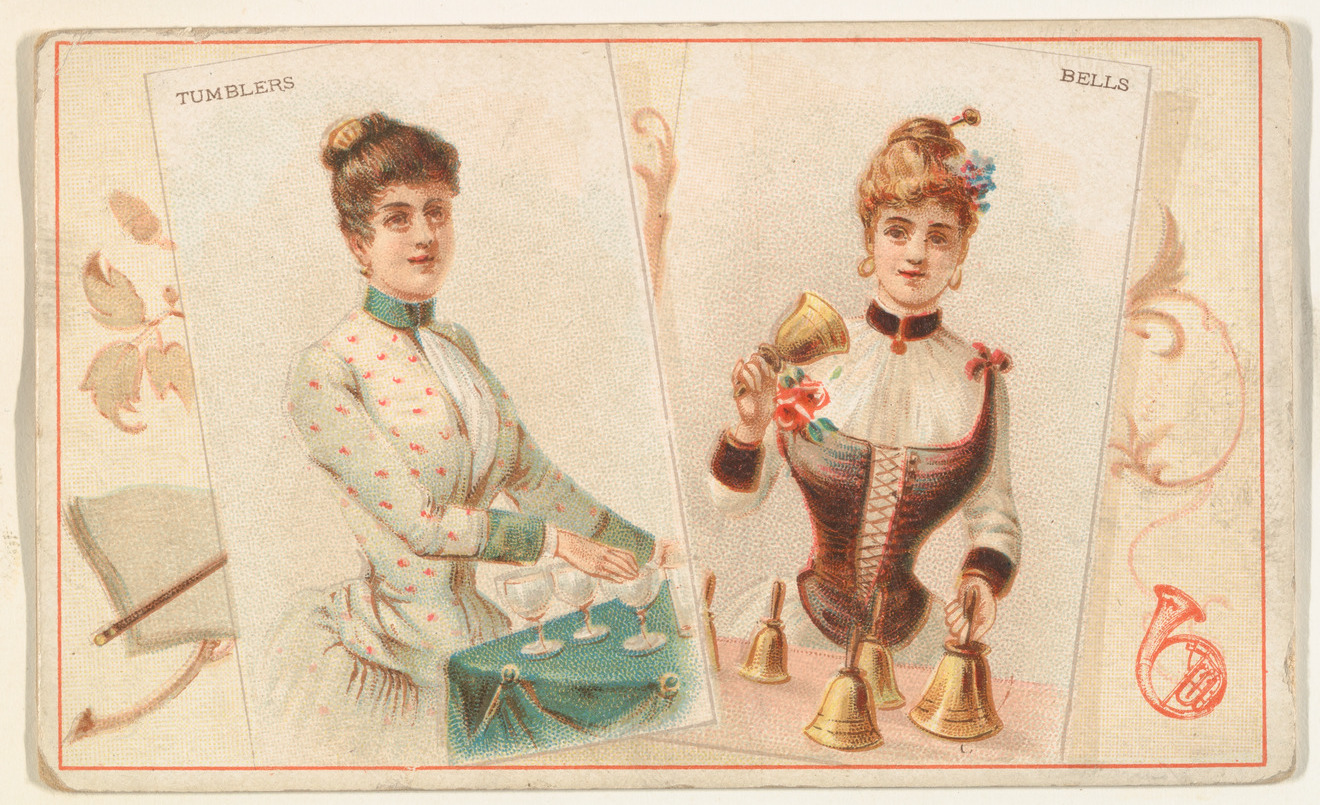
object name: print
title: Tumblers and Bells, from the Musical Instruments series (N121) issued by Duke Sons & Co. to promote Honest Long Cut Tobacco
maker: w. duke, sons & co.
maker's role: publisher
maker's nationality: american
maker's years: 1870-1920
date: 1888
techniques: color lithograph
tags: women